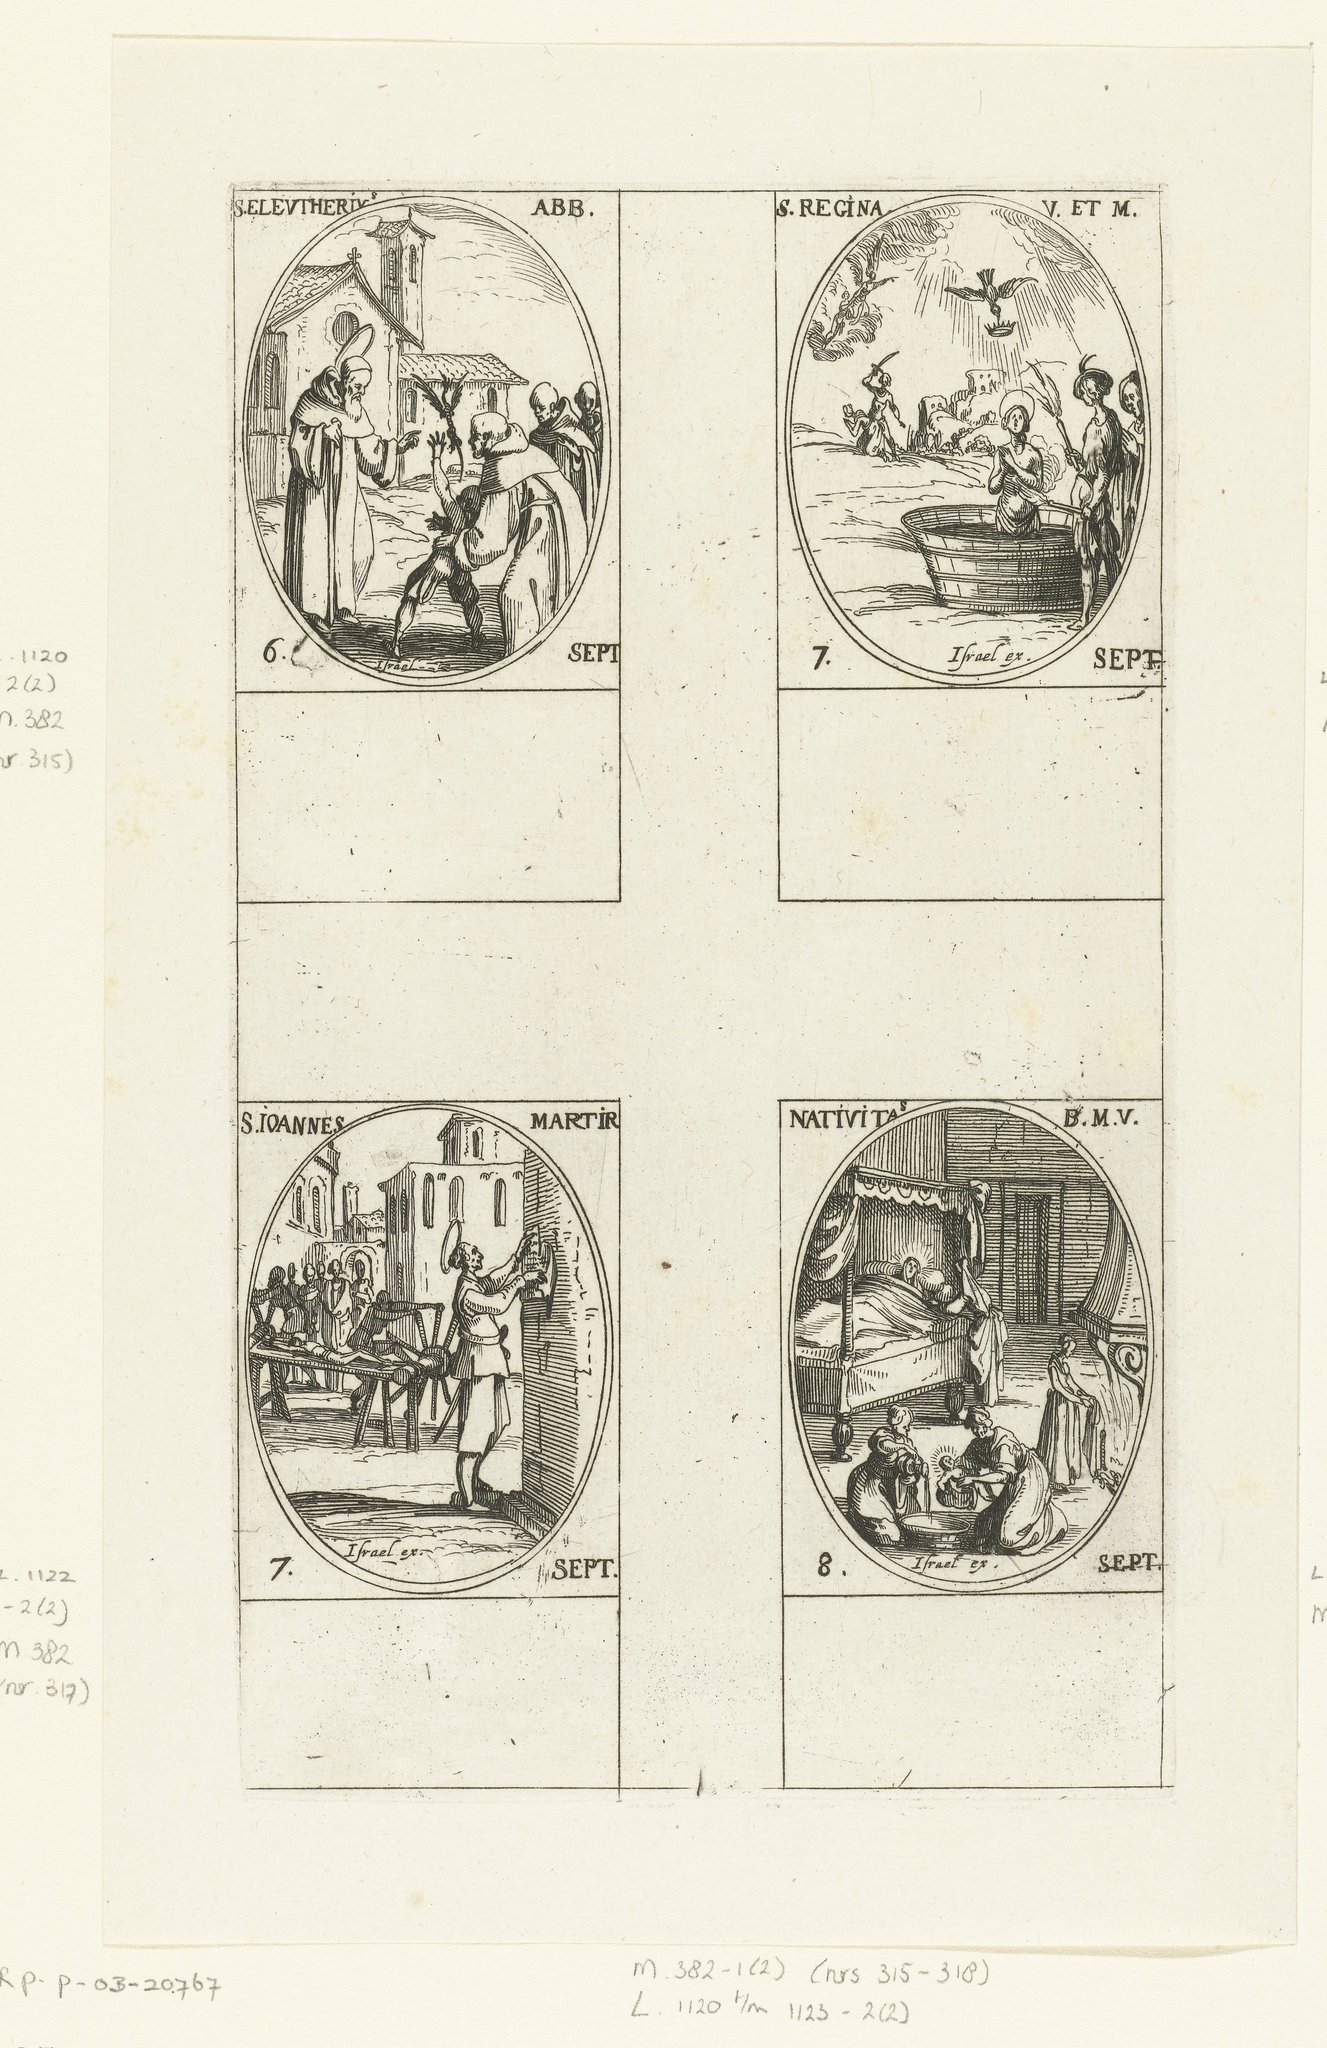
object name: print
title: Alle heiligen en de Christelijke feestdagen van het jaar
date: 1632-1636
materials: paper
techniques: etching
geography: nancy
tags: birth of mary, male saints (with name), female saints (with name)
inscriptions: collector's mark: Lugt 240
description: Blad met vier ovale voorstellingen, elk met opschrift en datum in het Latijn: linksboven de Heilige Eleutherius van Spoleto die een duivel bij een kind uitdrijft, rechtsboven de Heilige Regina van Alise-Sainte-Reine in een tobbe, linksonder de Heilige Johannes Martyr die een vel papier aan een muur bevestigt, rechtsonder de pasgeboren Maria die in bad gedaan wordt. Deze prent is onderdeel van een serie prenten met voorstellingen van de heiligen en de christelijke feestdagen van het jaar. Er zijn steeds vier scènes van één plaat op één blad gedrukt. Inclusief bijbehorend titelblad en frontispice gaat het in totaal om 124 platen (490 voorstellingen). De drie platen met de laatste 12 scènes (de veranderlijke christelijke feestdagen) zijn in de derde staat versneden tot 12 kleine plaatjes, en met een apart titelblad uitgegeven.